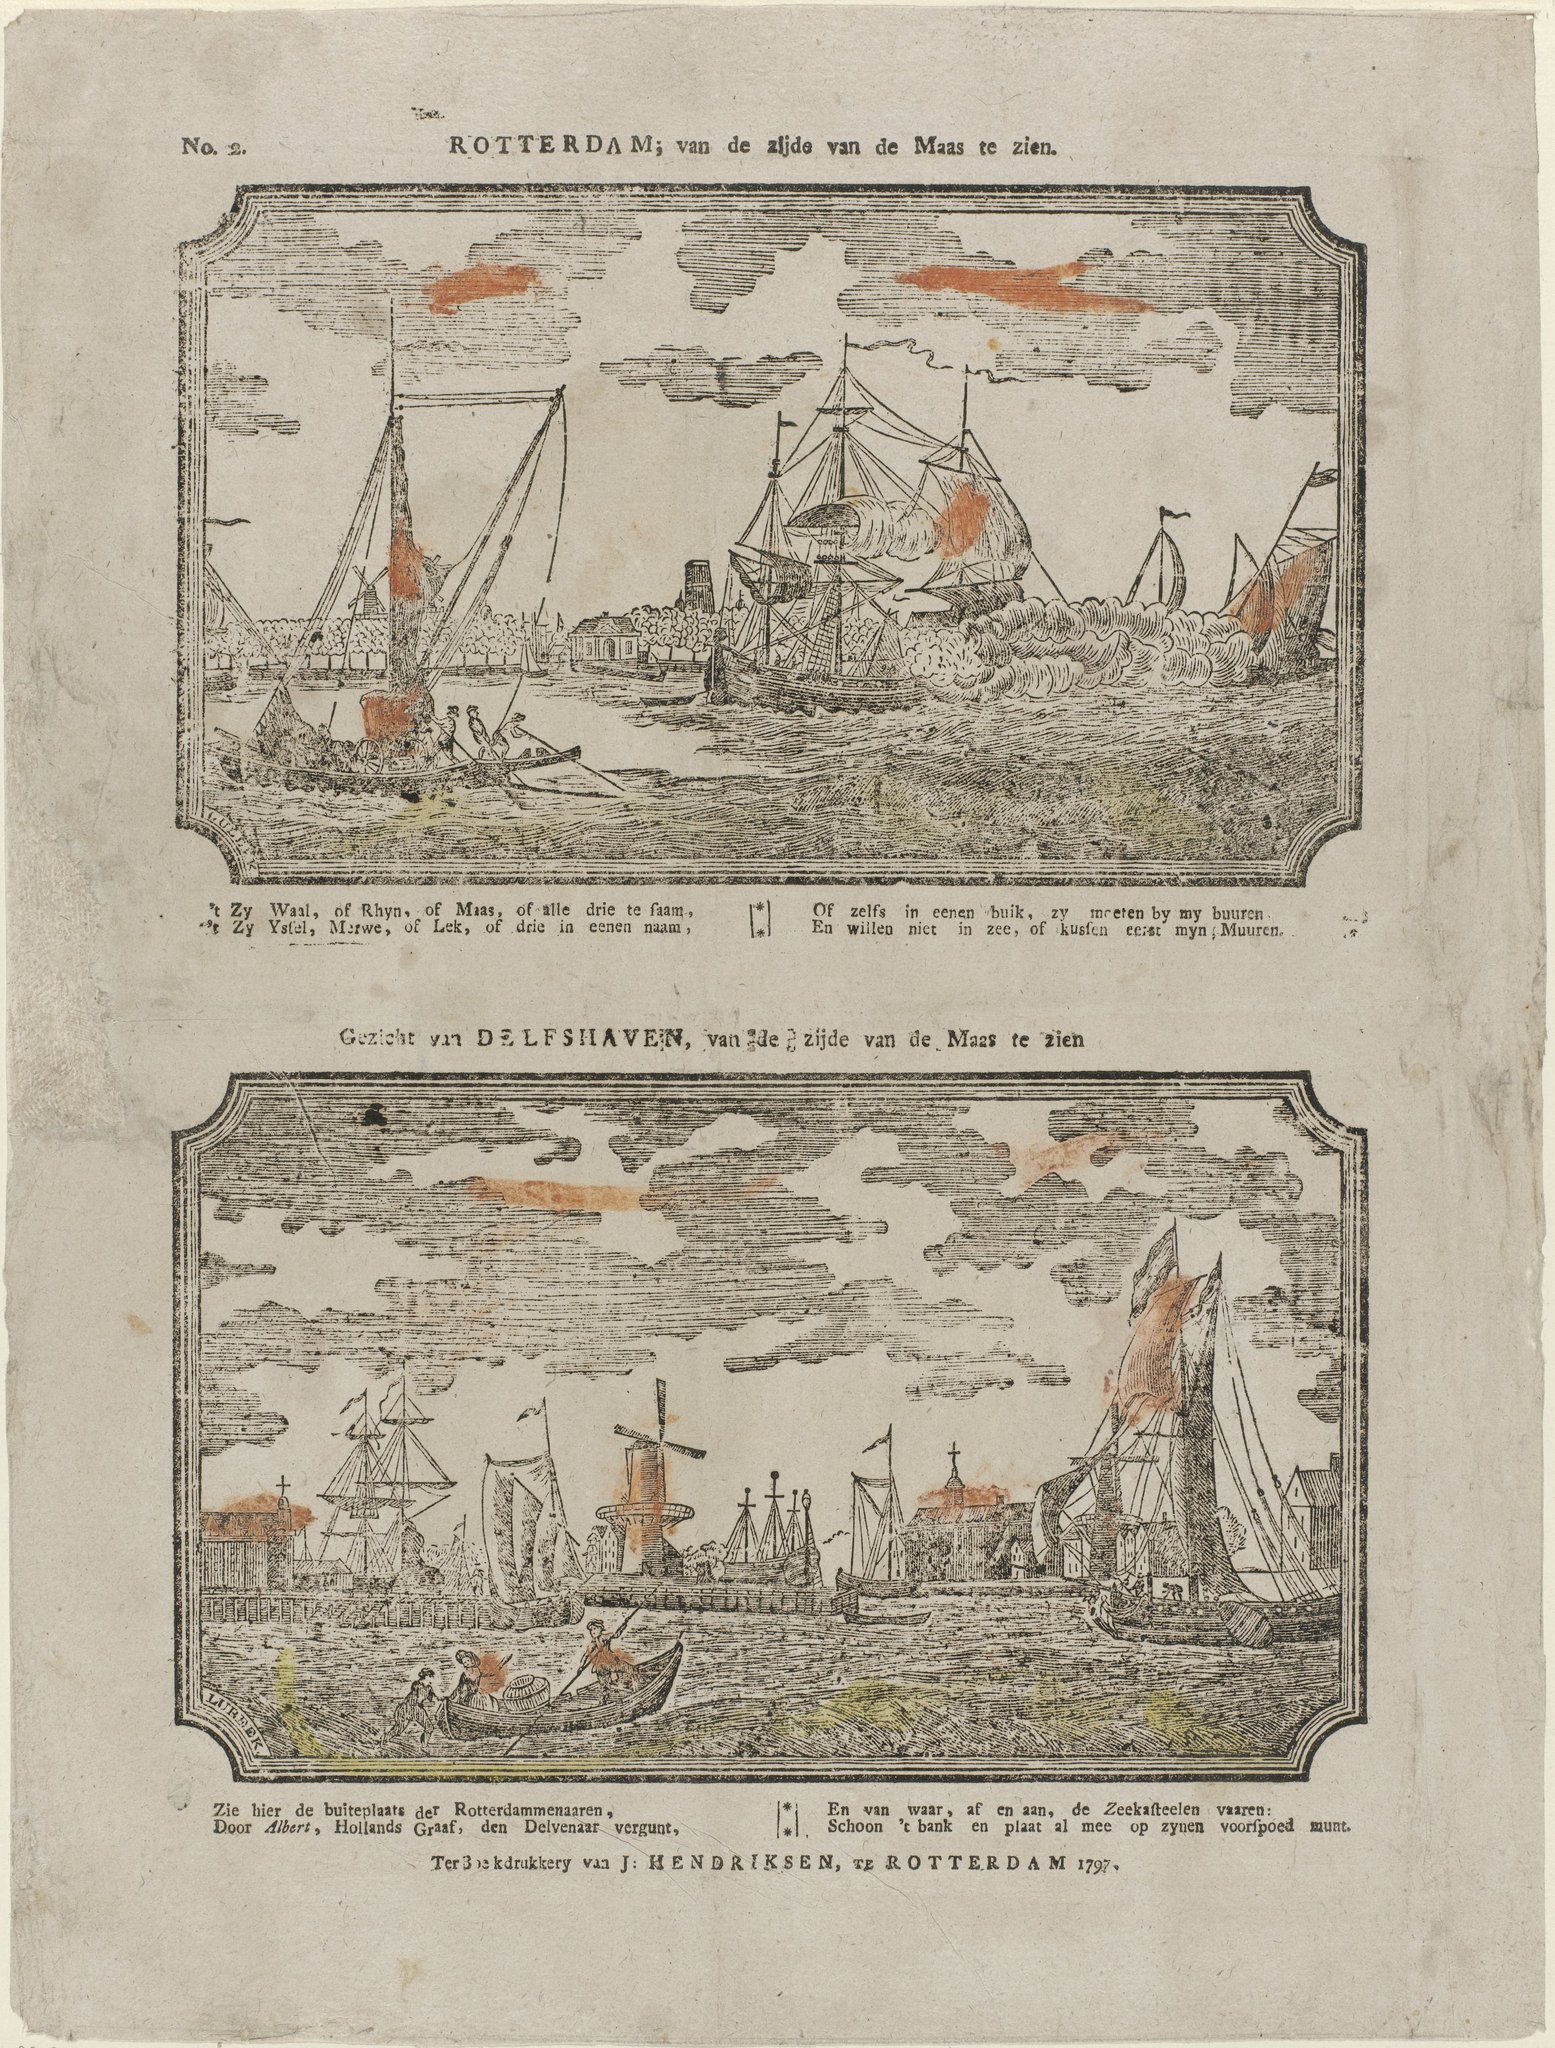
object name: popular print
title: Rotterdam, van de zijde van de Maas te zien / Gezicht van Delfshaven, van de zijde van de Maas te zien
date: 1797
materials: paper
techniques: colour, letterpress printing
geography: rotterdam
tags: river, ships (in general), delfshaven, rotterdam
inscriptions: collector's mark: Lugt 2760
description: Blad met 2 voorstellingen. Boven: een gezicht op Rotterdam vanaf de Maas gezien. Onder: een gezicht op Delshaven vanaf de Maas gezien. Onder de afbeeldingen een onderschrift. Genummerd linksboven: No. 2.